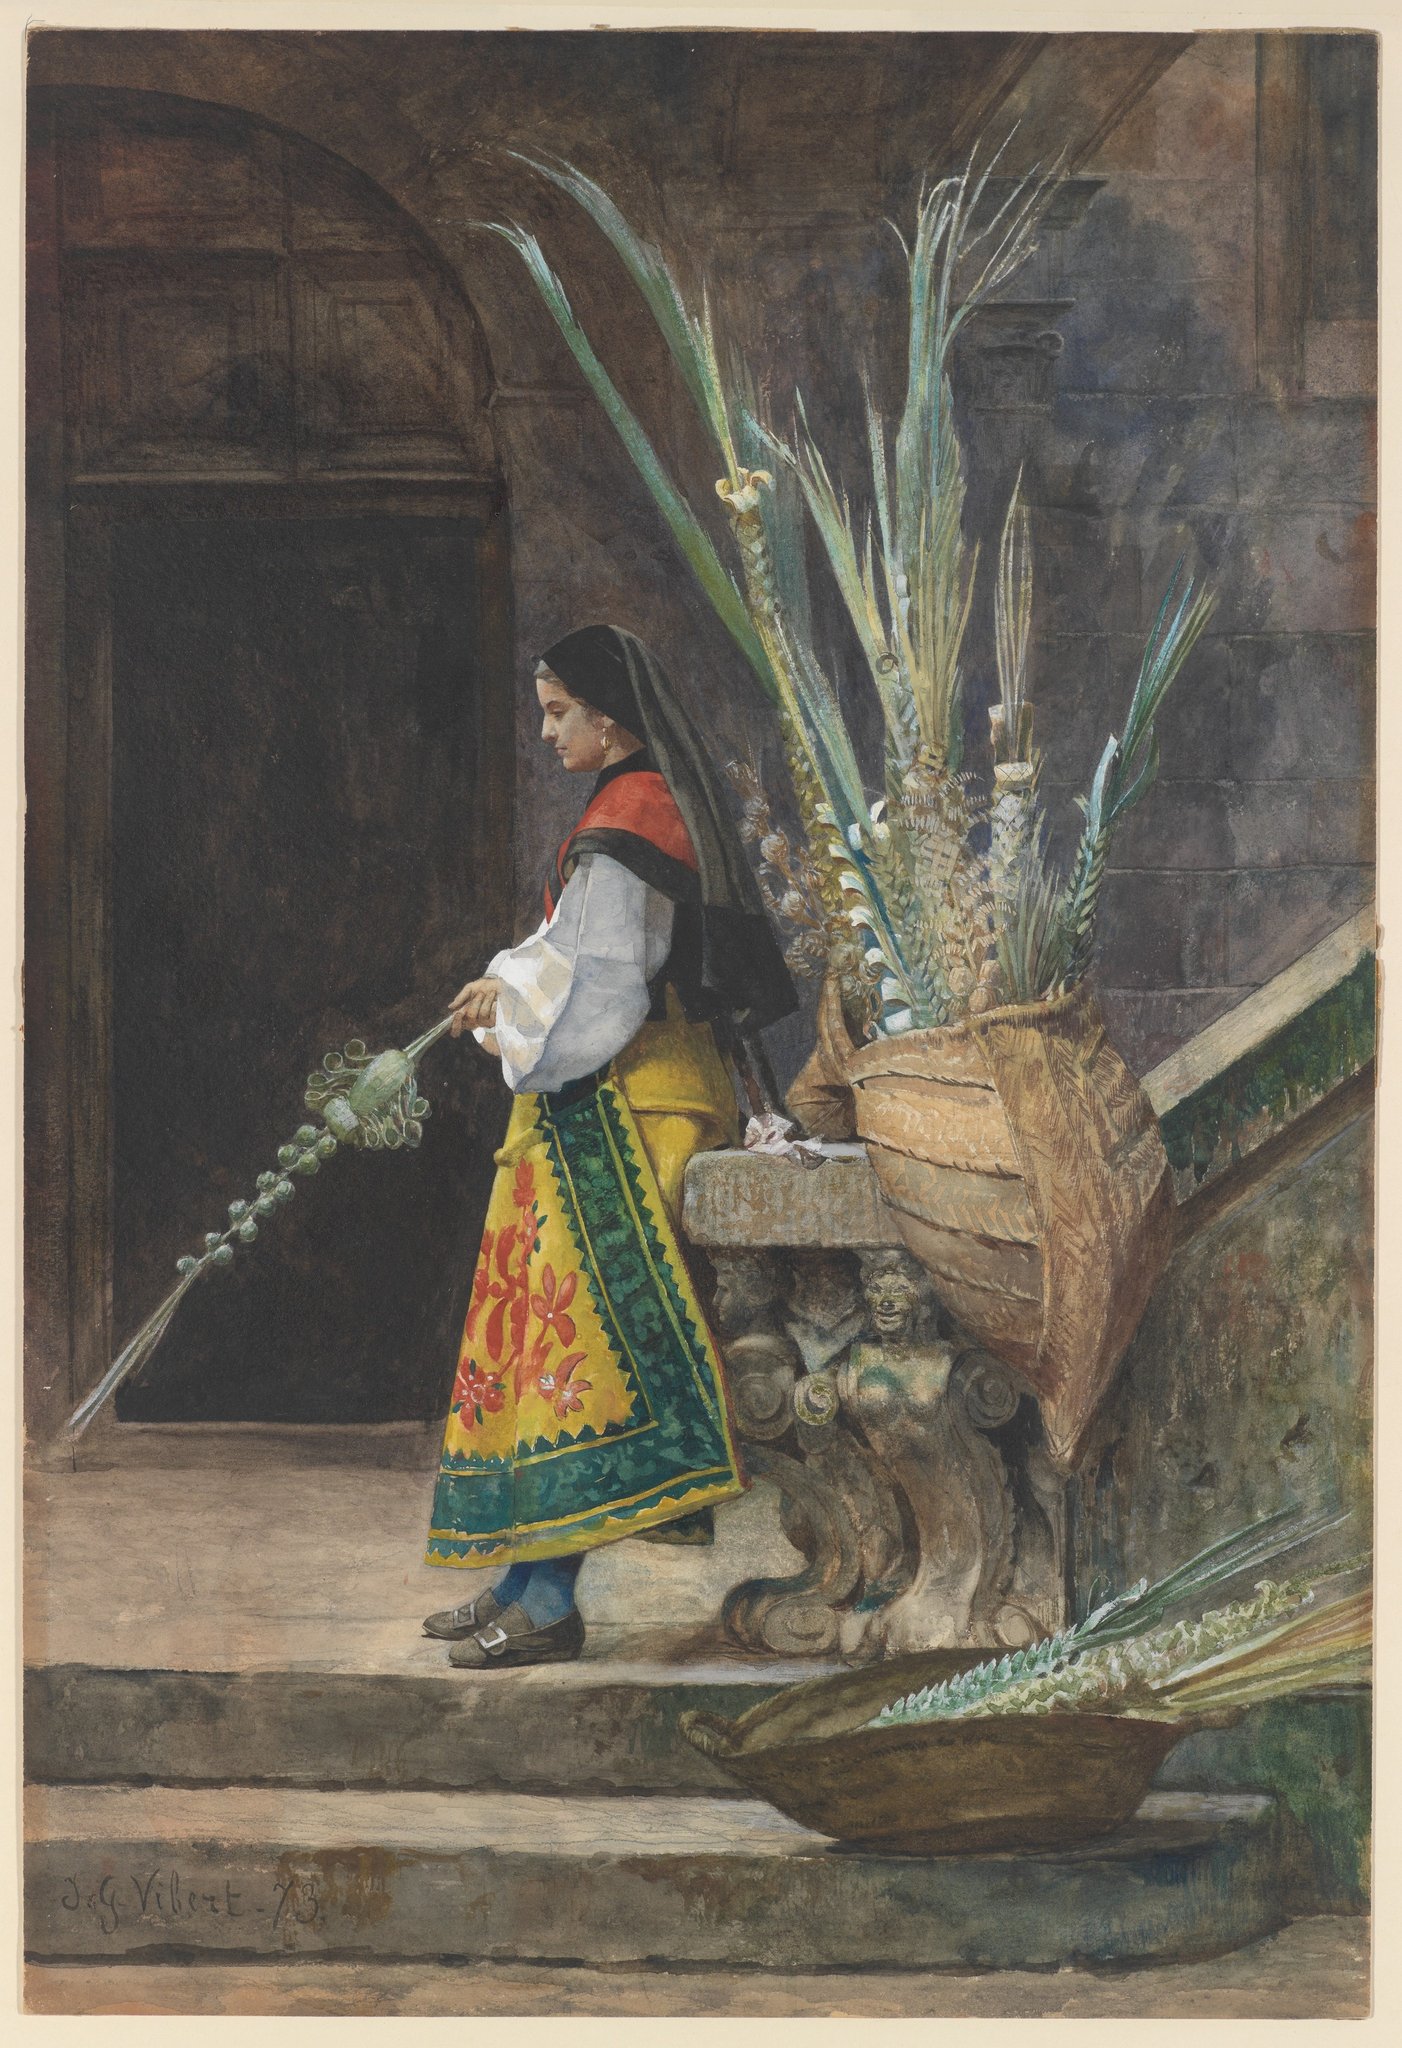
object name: drawing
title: Palm Sunday in Spain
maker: jean-georges vibert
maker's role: artist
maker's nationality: french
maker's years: 1840-1902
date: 1873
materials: watercolor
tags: doors,men